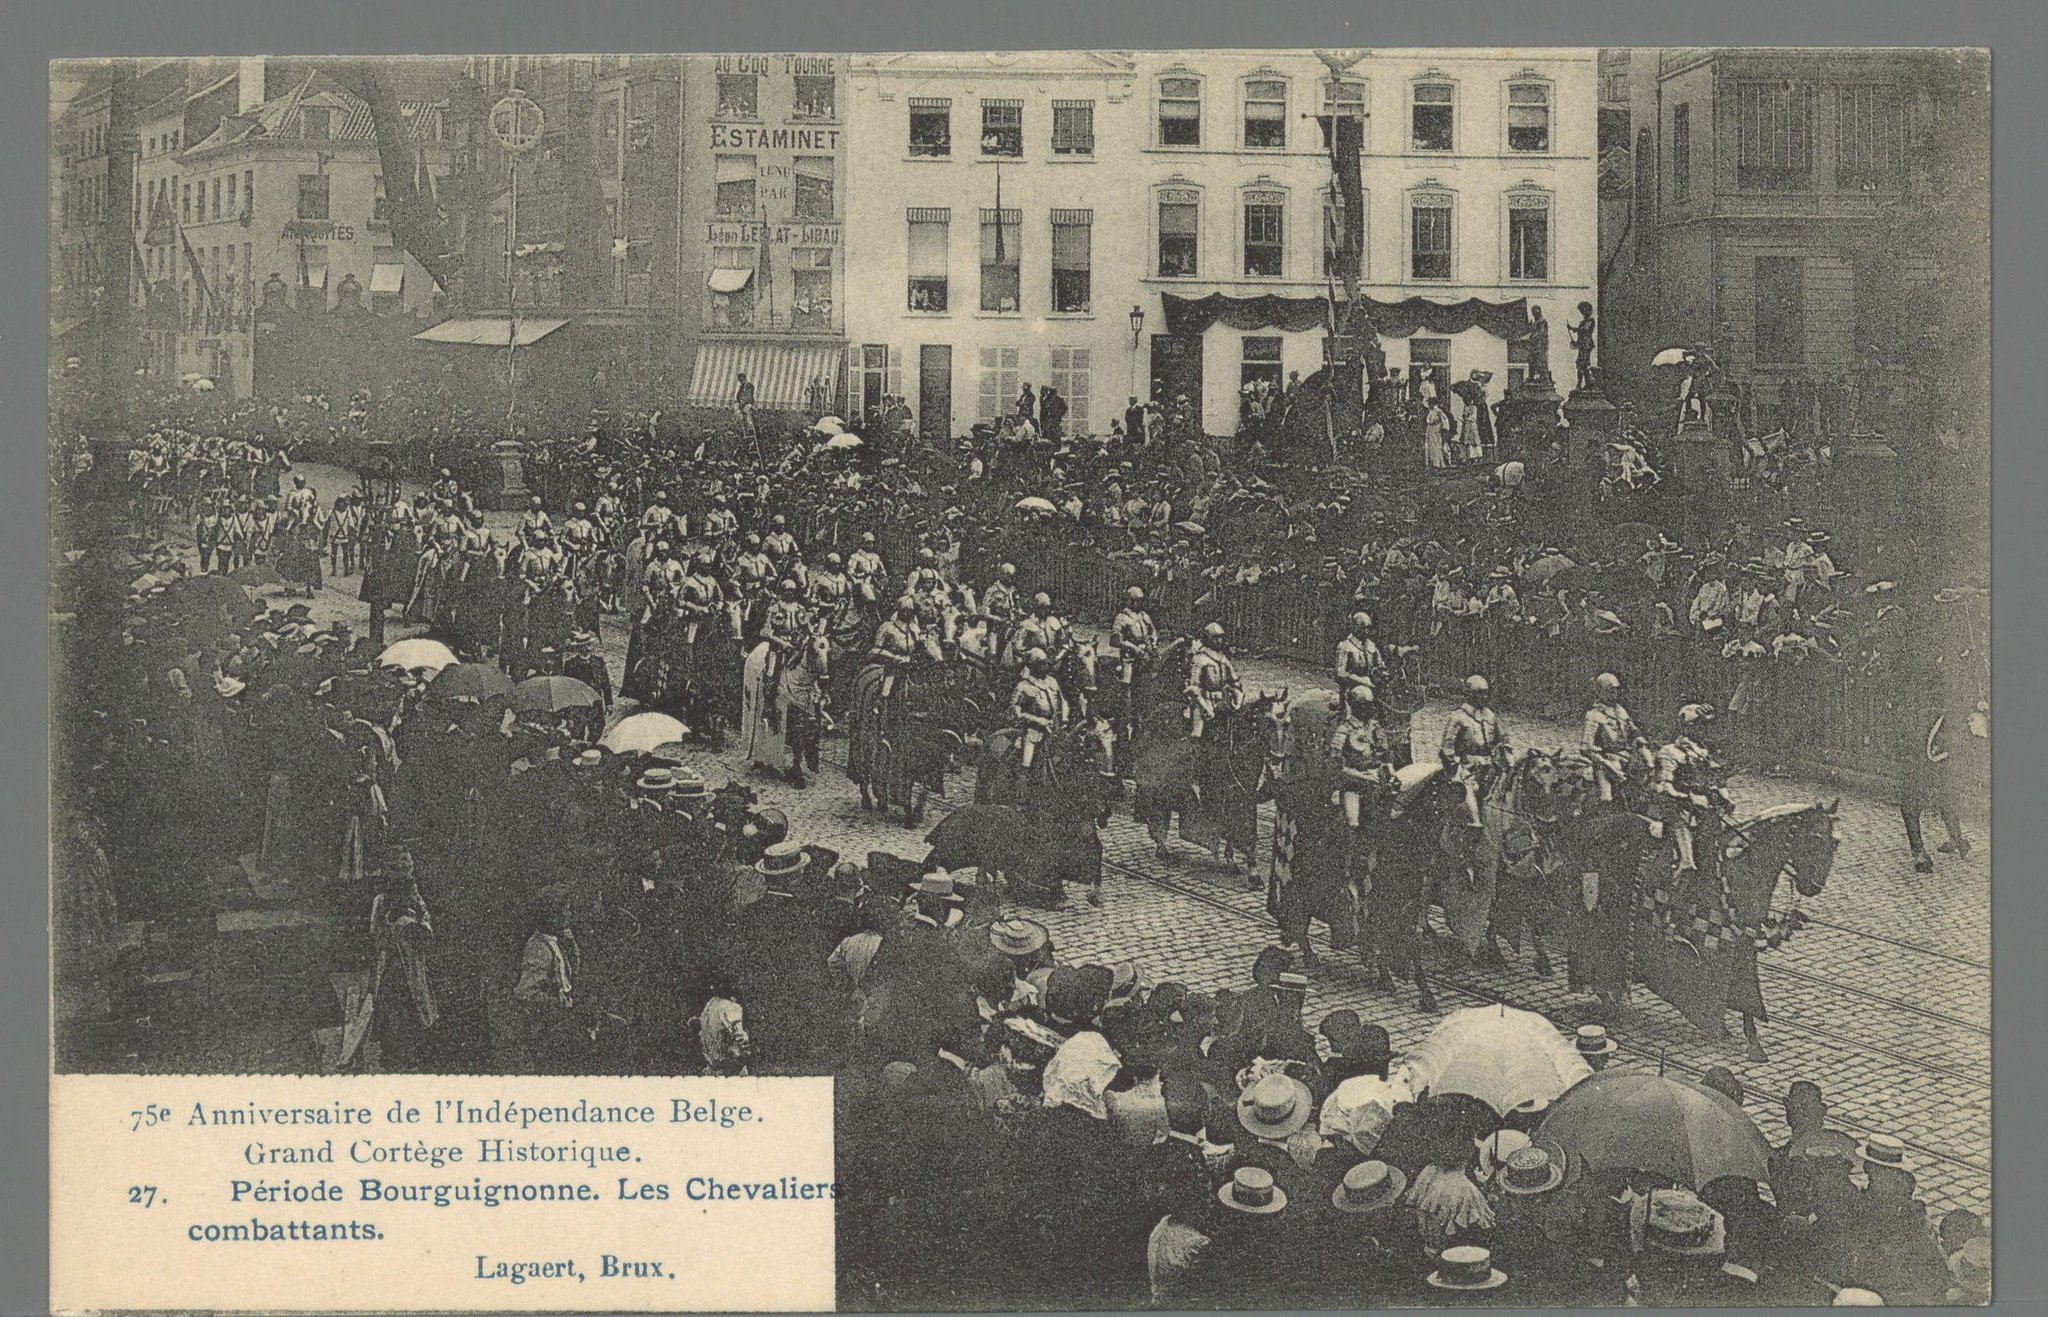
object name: photomechanical print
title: Période Bourguignonne. Les Chevaliers combattants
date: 1905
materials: cardboard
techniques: photograph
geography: brussels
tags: city-view, and landscape with man-made constructions (+ city(-scape) with figures, staffage), periodic celebrations, popular feasts, brussels